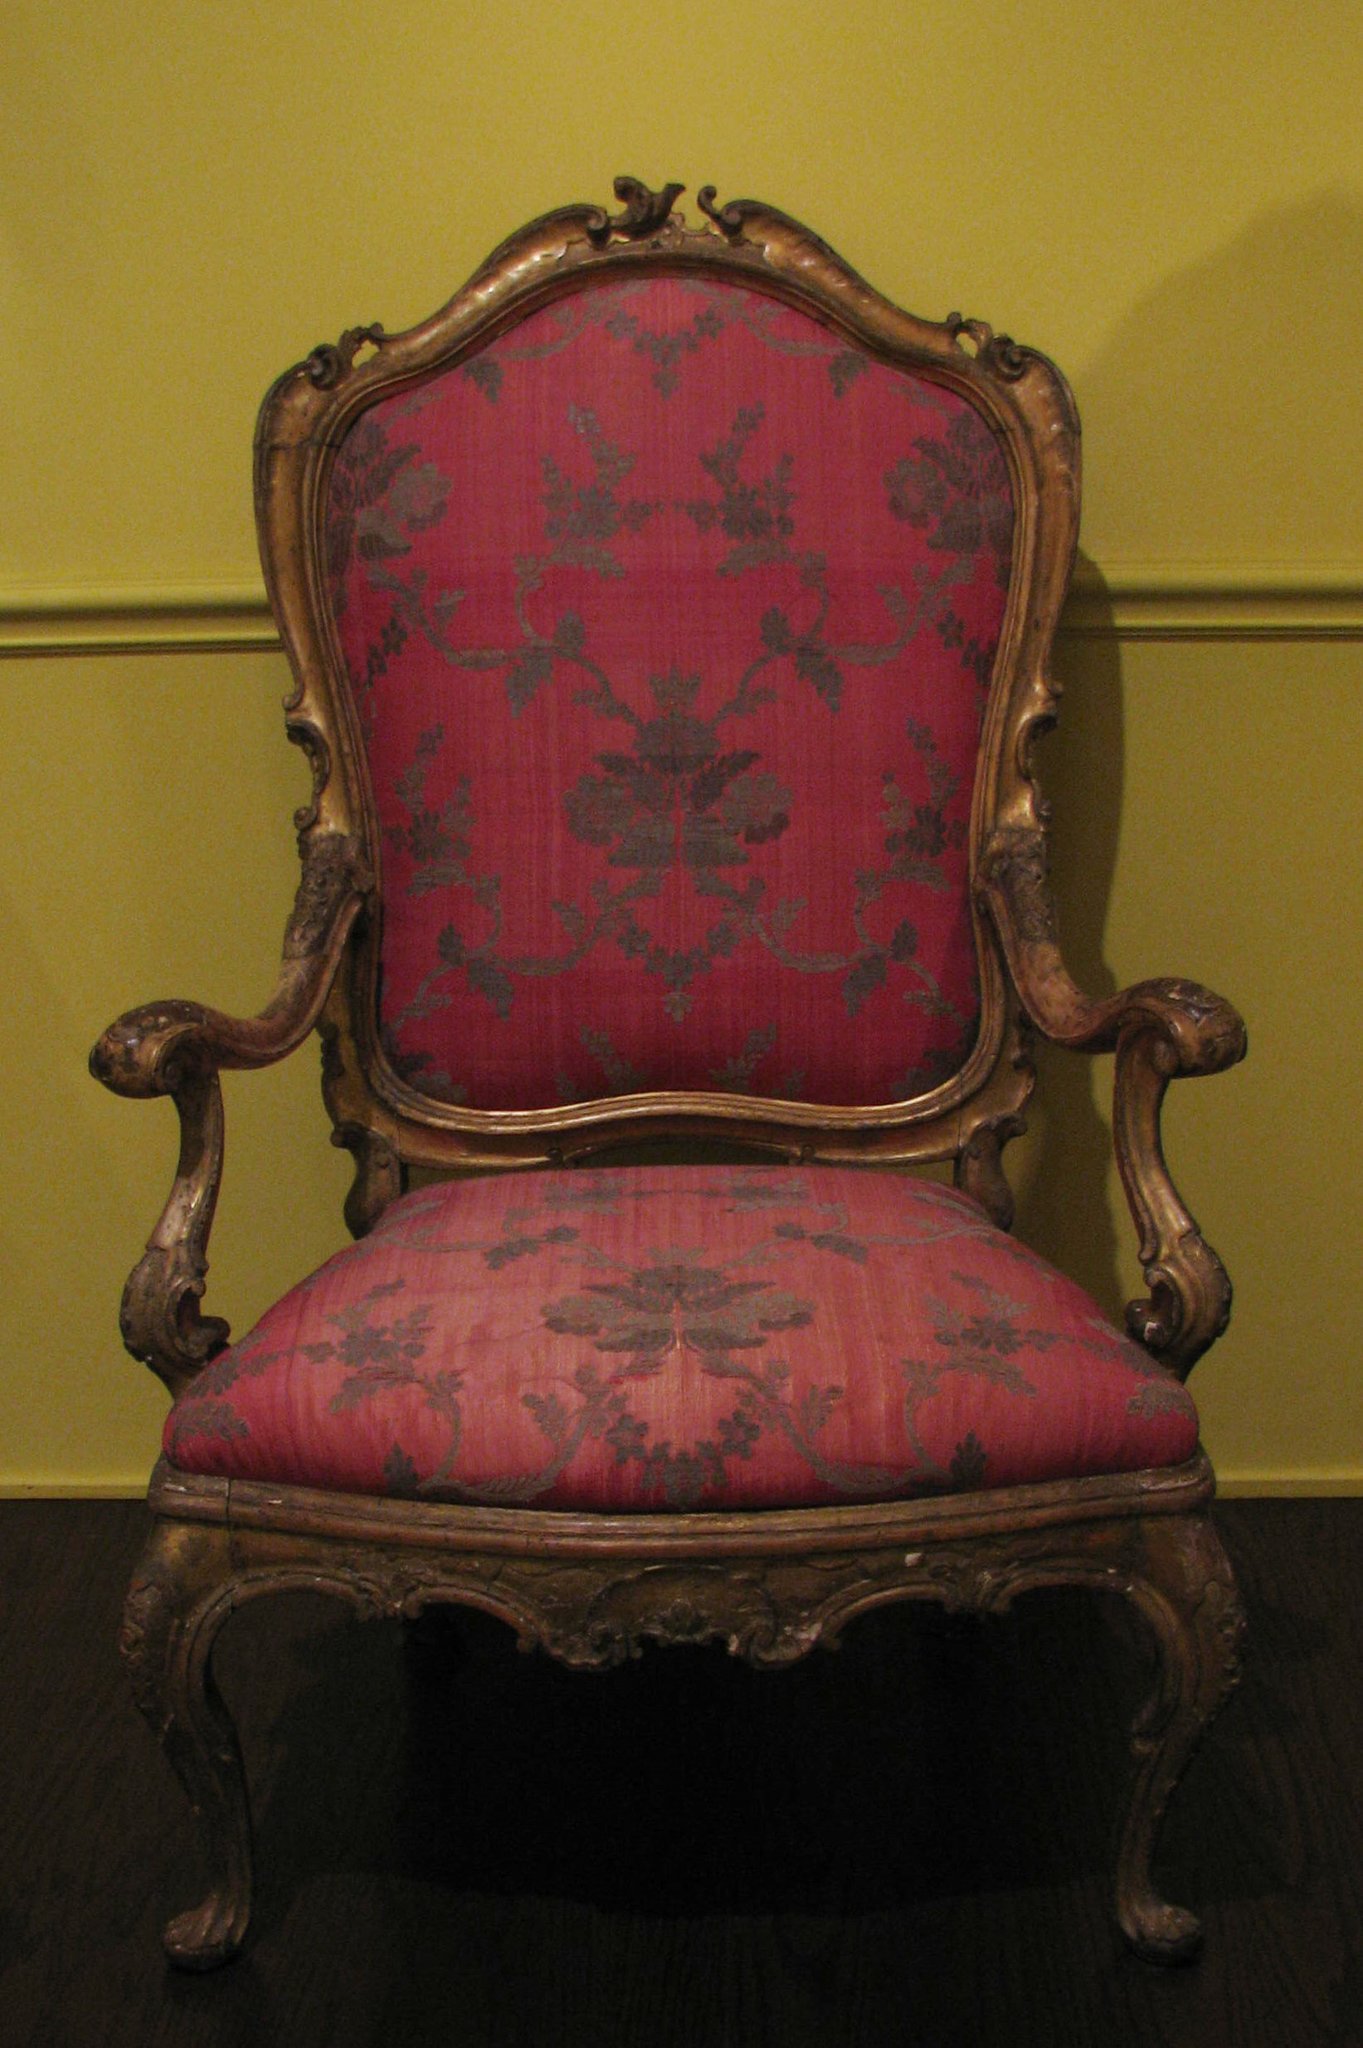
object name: armchair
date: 1701-1800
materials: gilt, velvet, wood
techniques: carving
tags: flowers